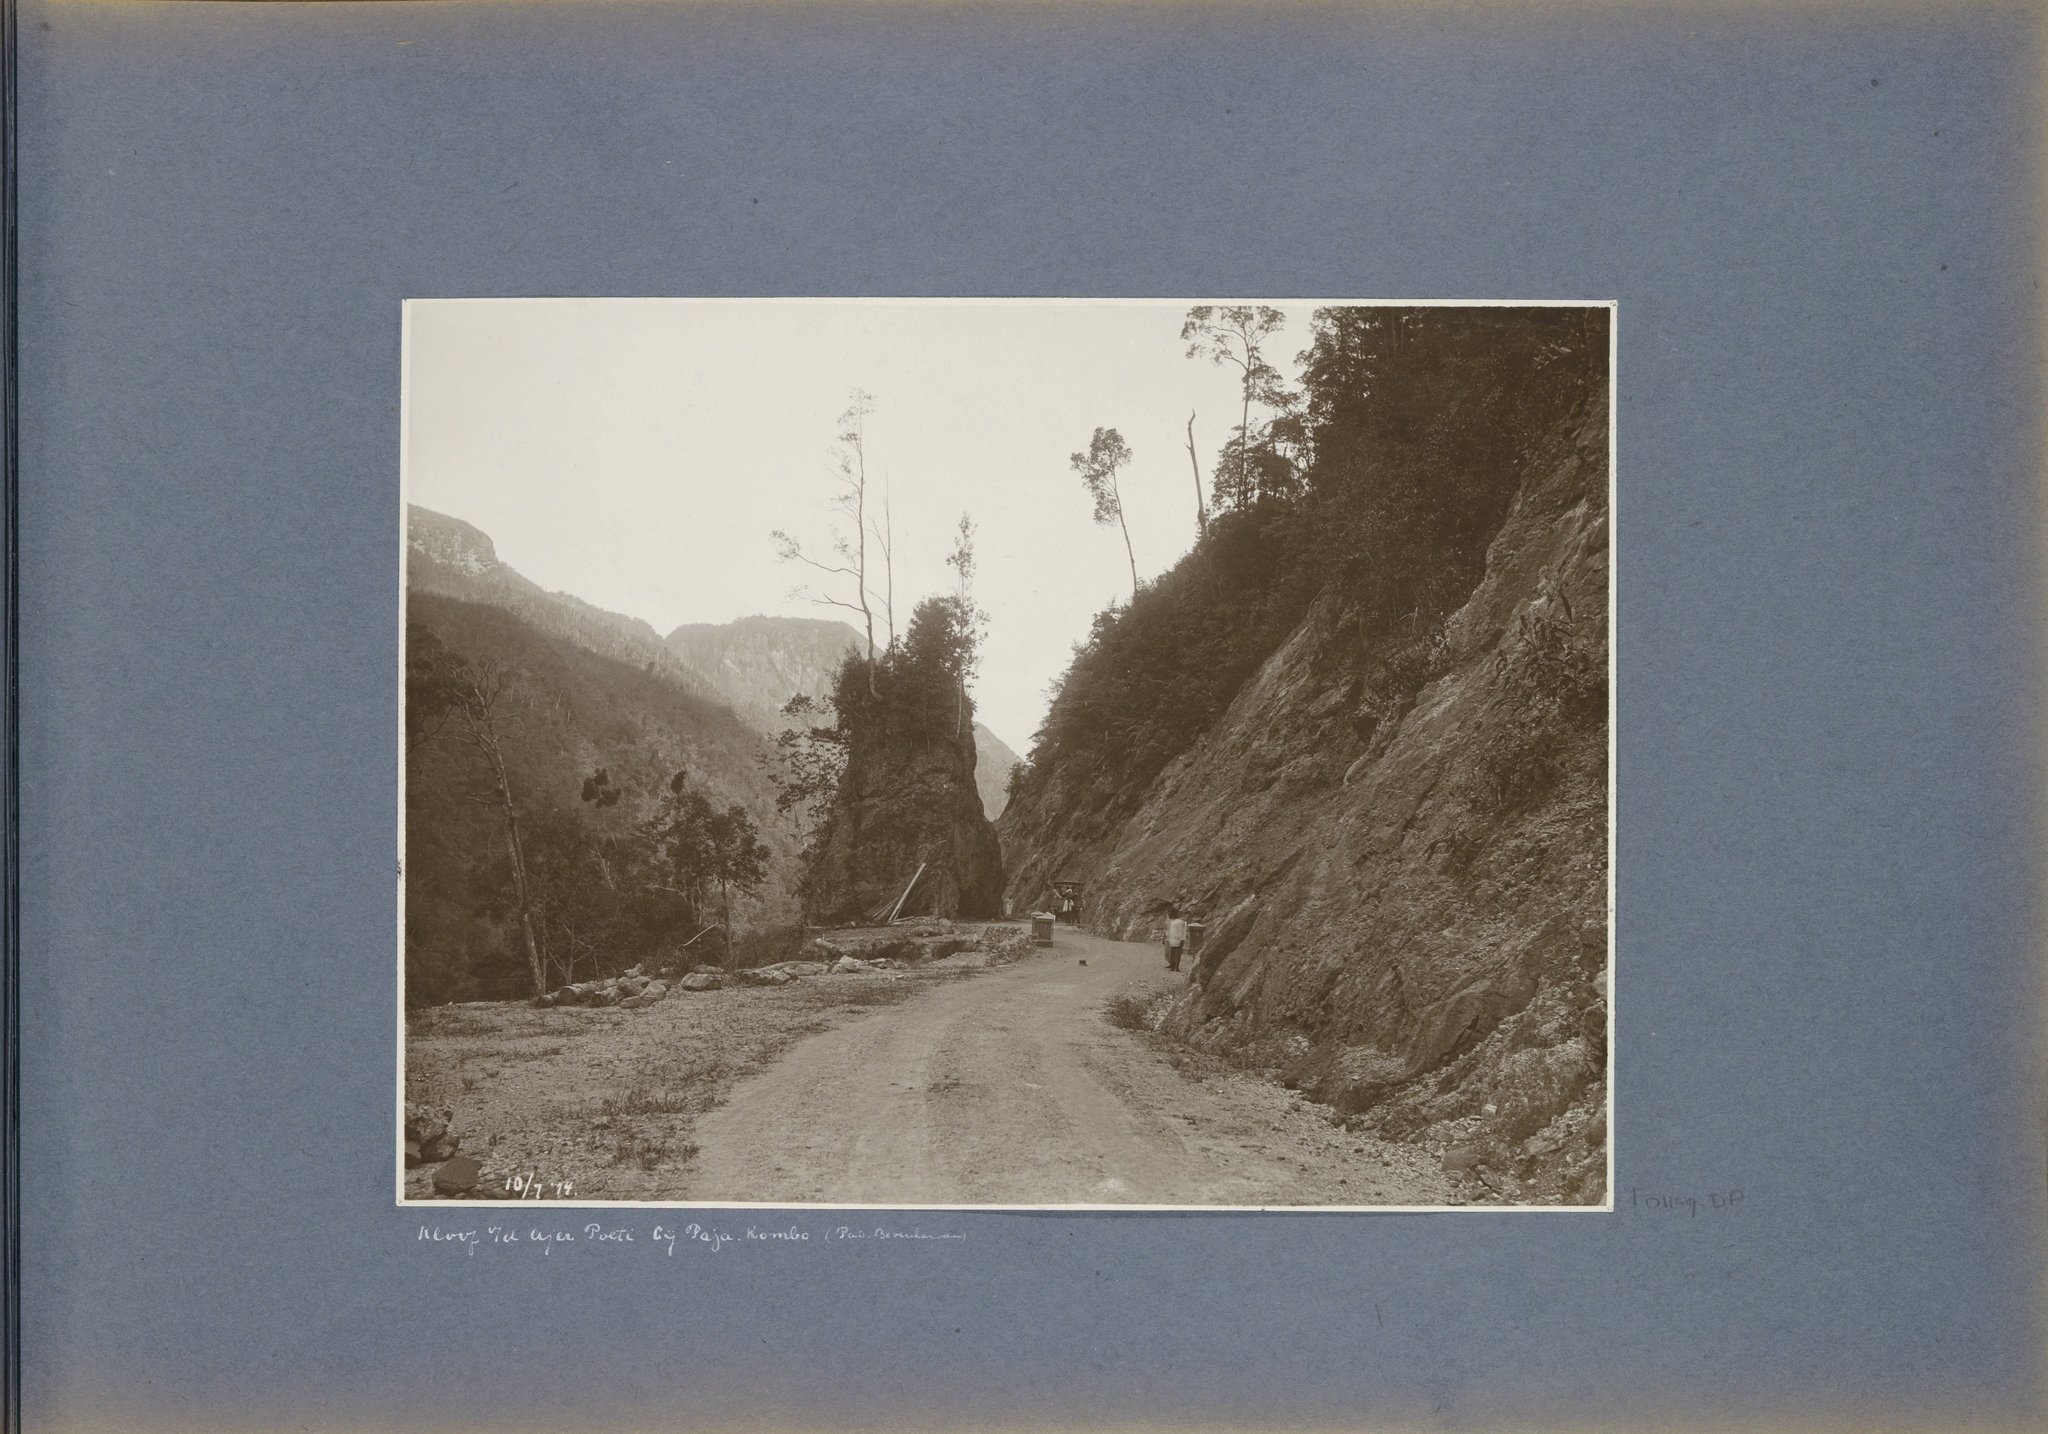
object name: photograph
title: Kloof van de Ajer Poetirivier bij Paja Kombo op Sumatra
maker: christiaan benjamin nieuwenhuis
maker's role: publisher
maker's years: 1863-1922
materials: paper, photographic support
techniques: gelatin silver print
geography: sumatra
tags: ravine, chasm, abyss, canyon, sumatra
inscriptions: date: ‘10/7 '14’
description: Onderdeel van reisalbum met foto's van bedrijvigheid en bezienswaardigheden op Sumatra en Java en van de reis naar en van Nederlands-Indië.